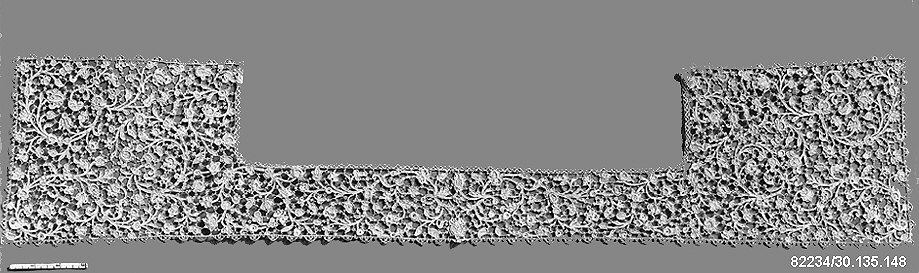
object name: collar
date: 1601-1700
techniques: lace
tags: flowers